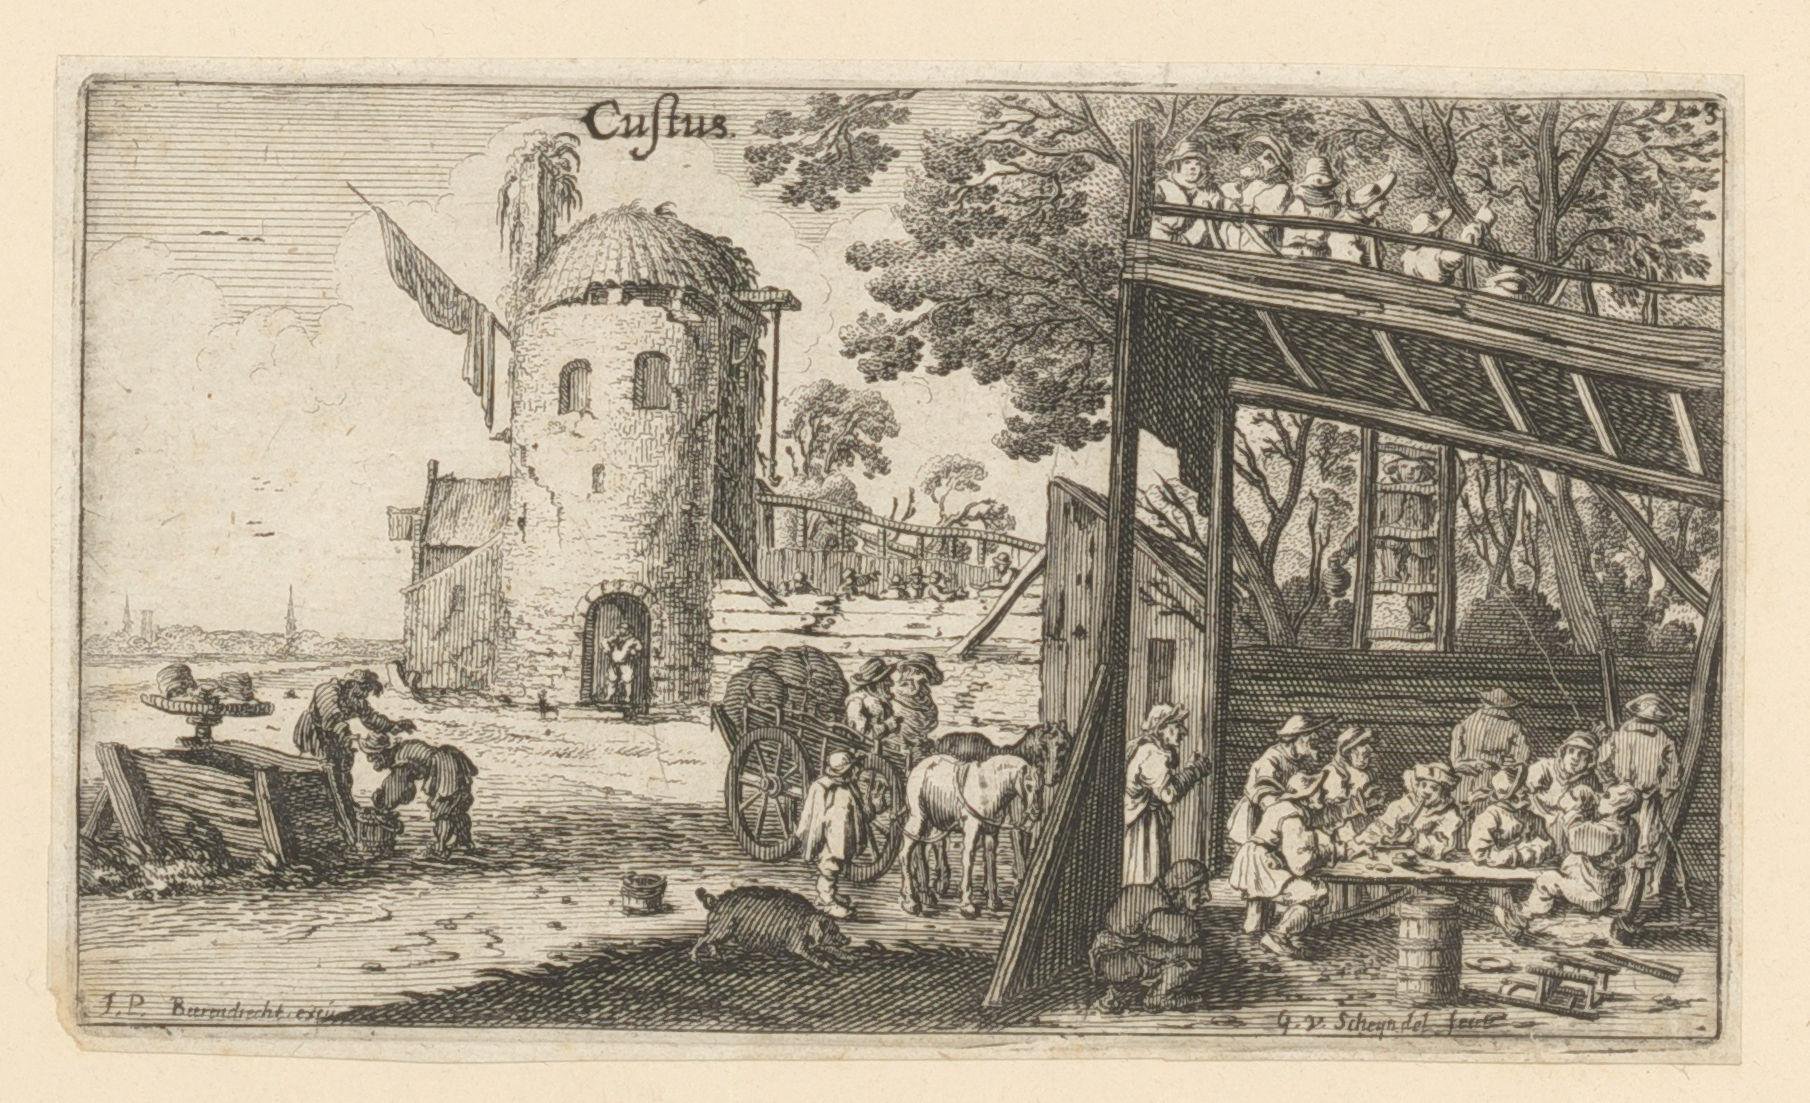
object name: print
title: Smaak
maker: gillis van scheyndel (i)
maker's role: draughtsman, print maker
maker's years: 1595-1660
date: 1618-1645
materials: paper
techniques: etching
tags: barn, taste, tasting (one of the five senses), pipe ~ tobacco, farmers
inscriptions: collector's mark: Lugt 1641, collector's mark: Lugt 963, stamp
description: De smaak. Rond een tafel in een open schuur zitten boeren te praten en te roken. Buiten de schuur en op het dak ook enkele mannen. De prent maakt deel uit van een serie van landschappen met de vijf zintuigen. Rechtsboven genummerd: 3. Onderwerpsrubrieken binnen de Atlas Zeden en Gewoonten: Zeden en Gewoonten in engeren zin. Volksleven. Zinnebeeldige voorstellingen uit het volkleven op serieprenten. Zintuigen.